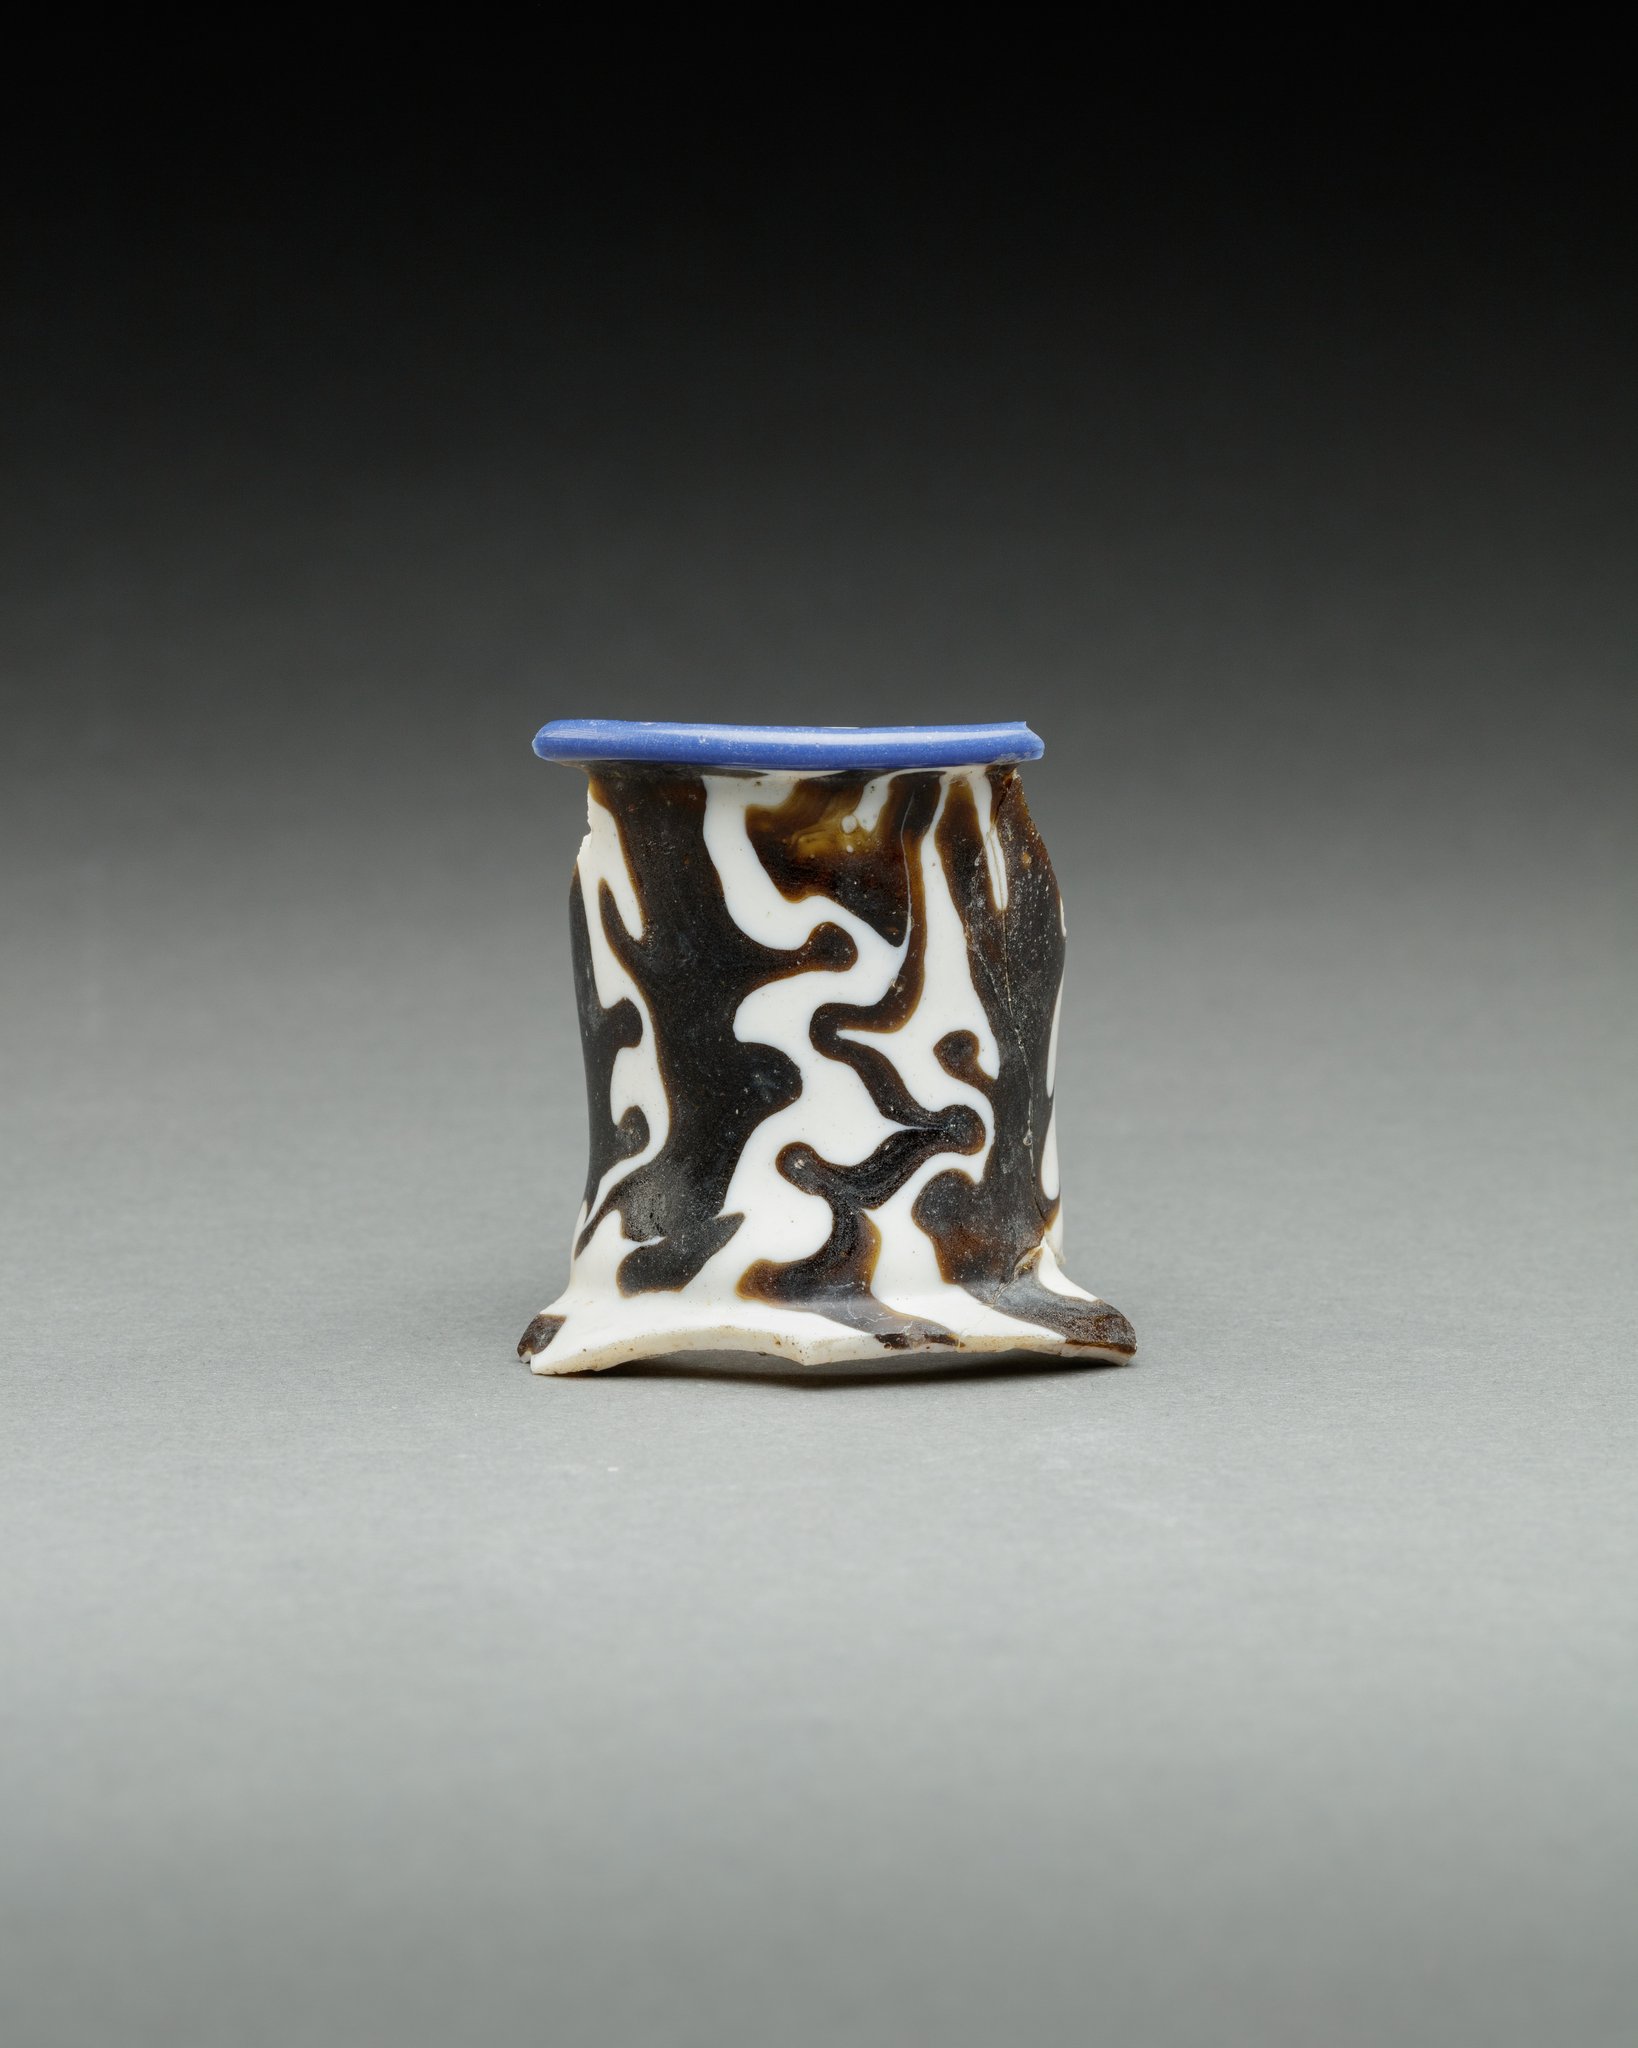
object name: bottle, rim fragment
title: Fragment of a Glass Bottle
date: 1427-1400 BCE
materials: glass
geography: egypt